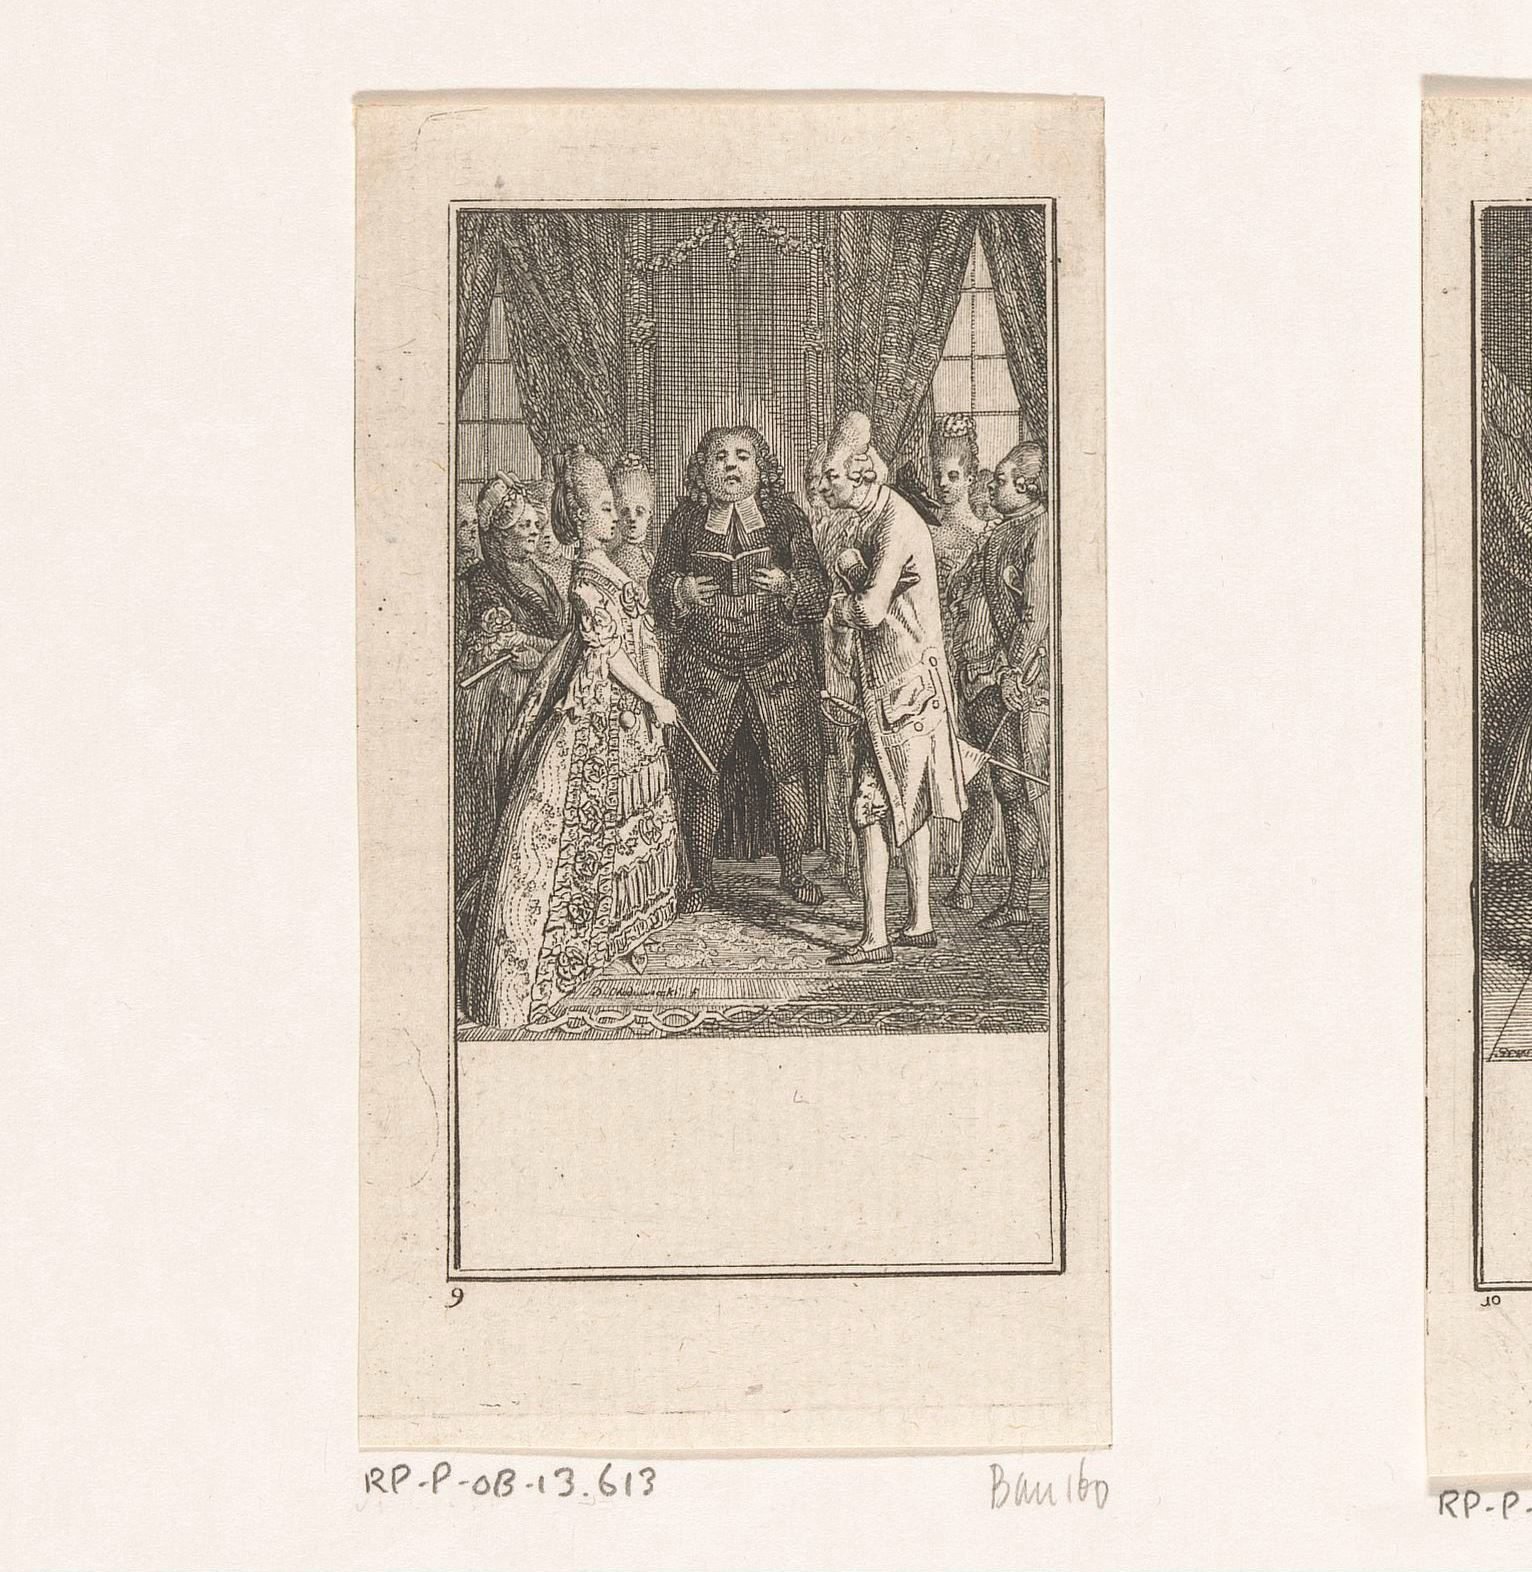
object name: print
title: Anfang der Häuslichen Glückseeligkeit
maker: daniel nikolaus chodowiecki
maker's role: draughtsman, print maker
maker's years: 1726-1801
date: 1773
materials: paper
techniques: etching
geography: berlin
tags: civil marriage ceremony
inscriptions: collector's mark: Lugt 2228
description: Negende prent uit een serie met 12 scènes uit 'een liederlijk leven'. De twaalf scènes werden samen op een plaat geëtst. De tweede staat van deze serie is gebruikt als illustratie in: 'Berliner genealogischen Calender auf das Jahr 1774'. Aan de hand van deze prentserie schreef Johann Christian Ludwig Haken (1767-1835) zijn briefroman 'Der Lüderliche'.